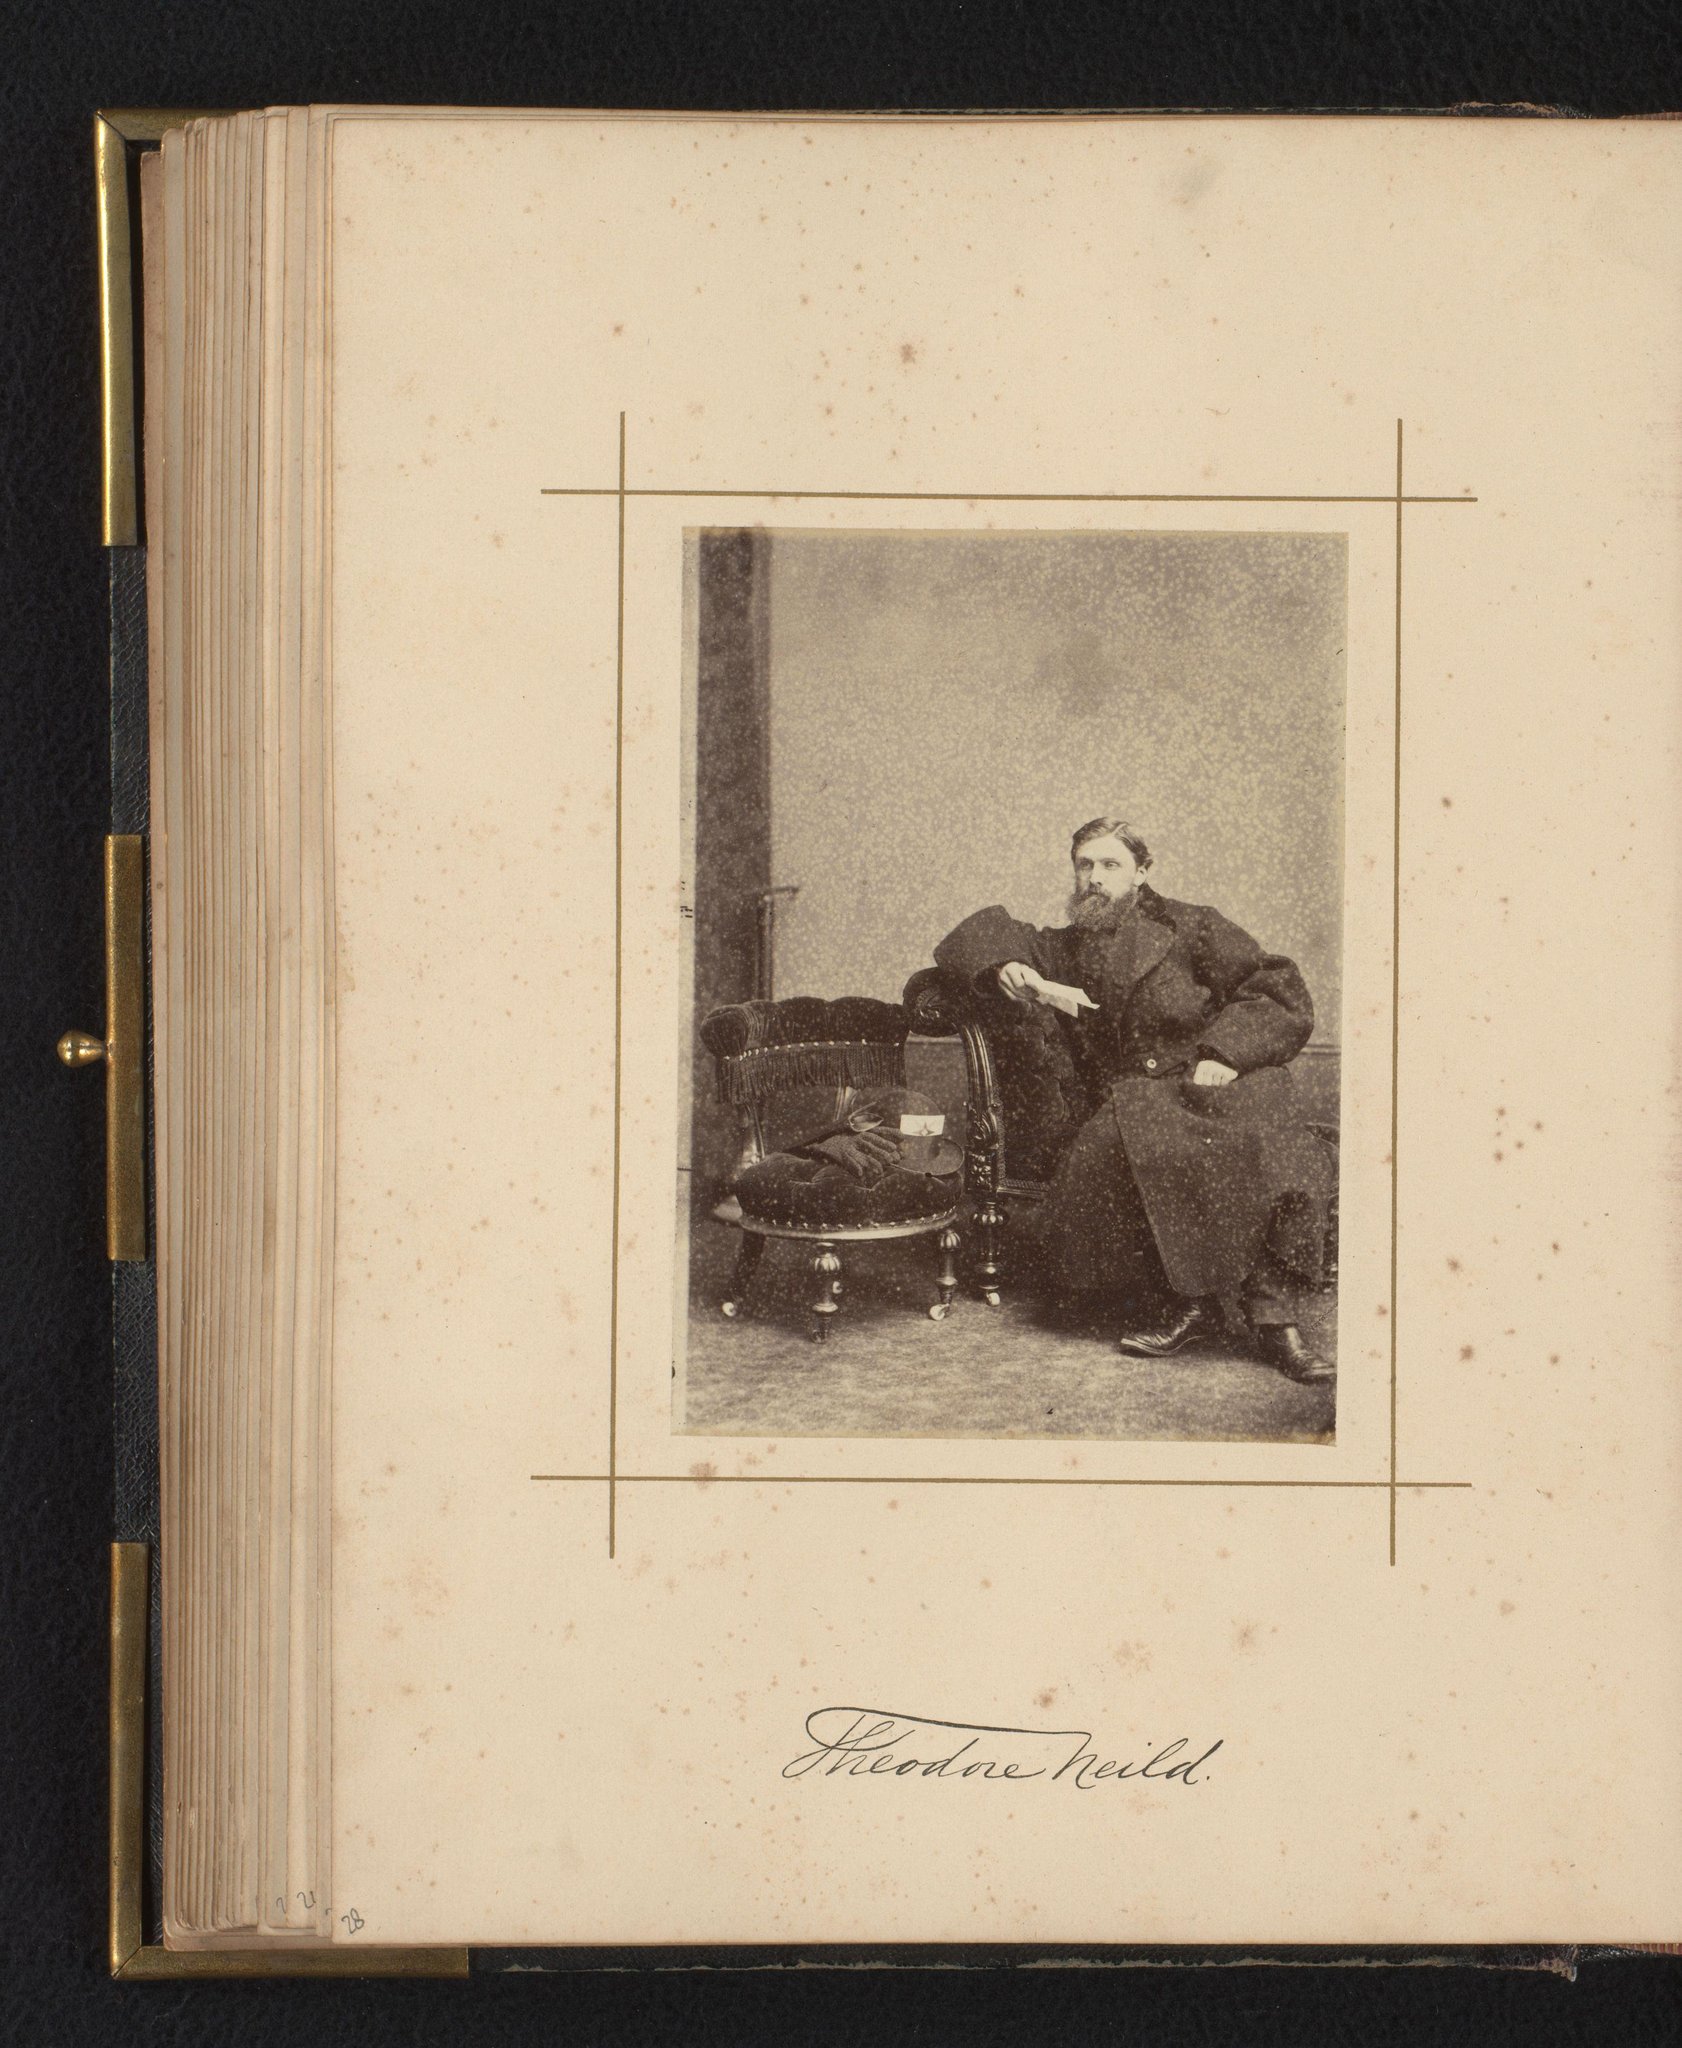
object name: page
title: Portret van Theodore Neild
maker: Anonymous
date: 1866-1871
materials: photographic support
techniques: albumen print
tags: sitting figure, historical persons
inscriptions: name: ‘Theodore Neild’